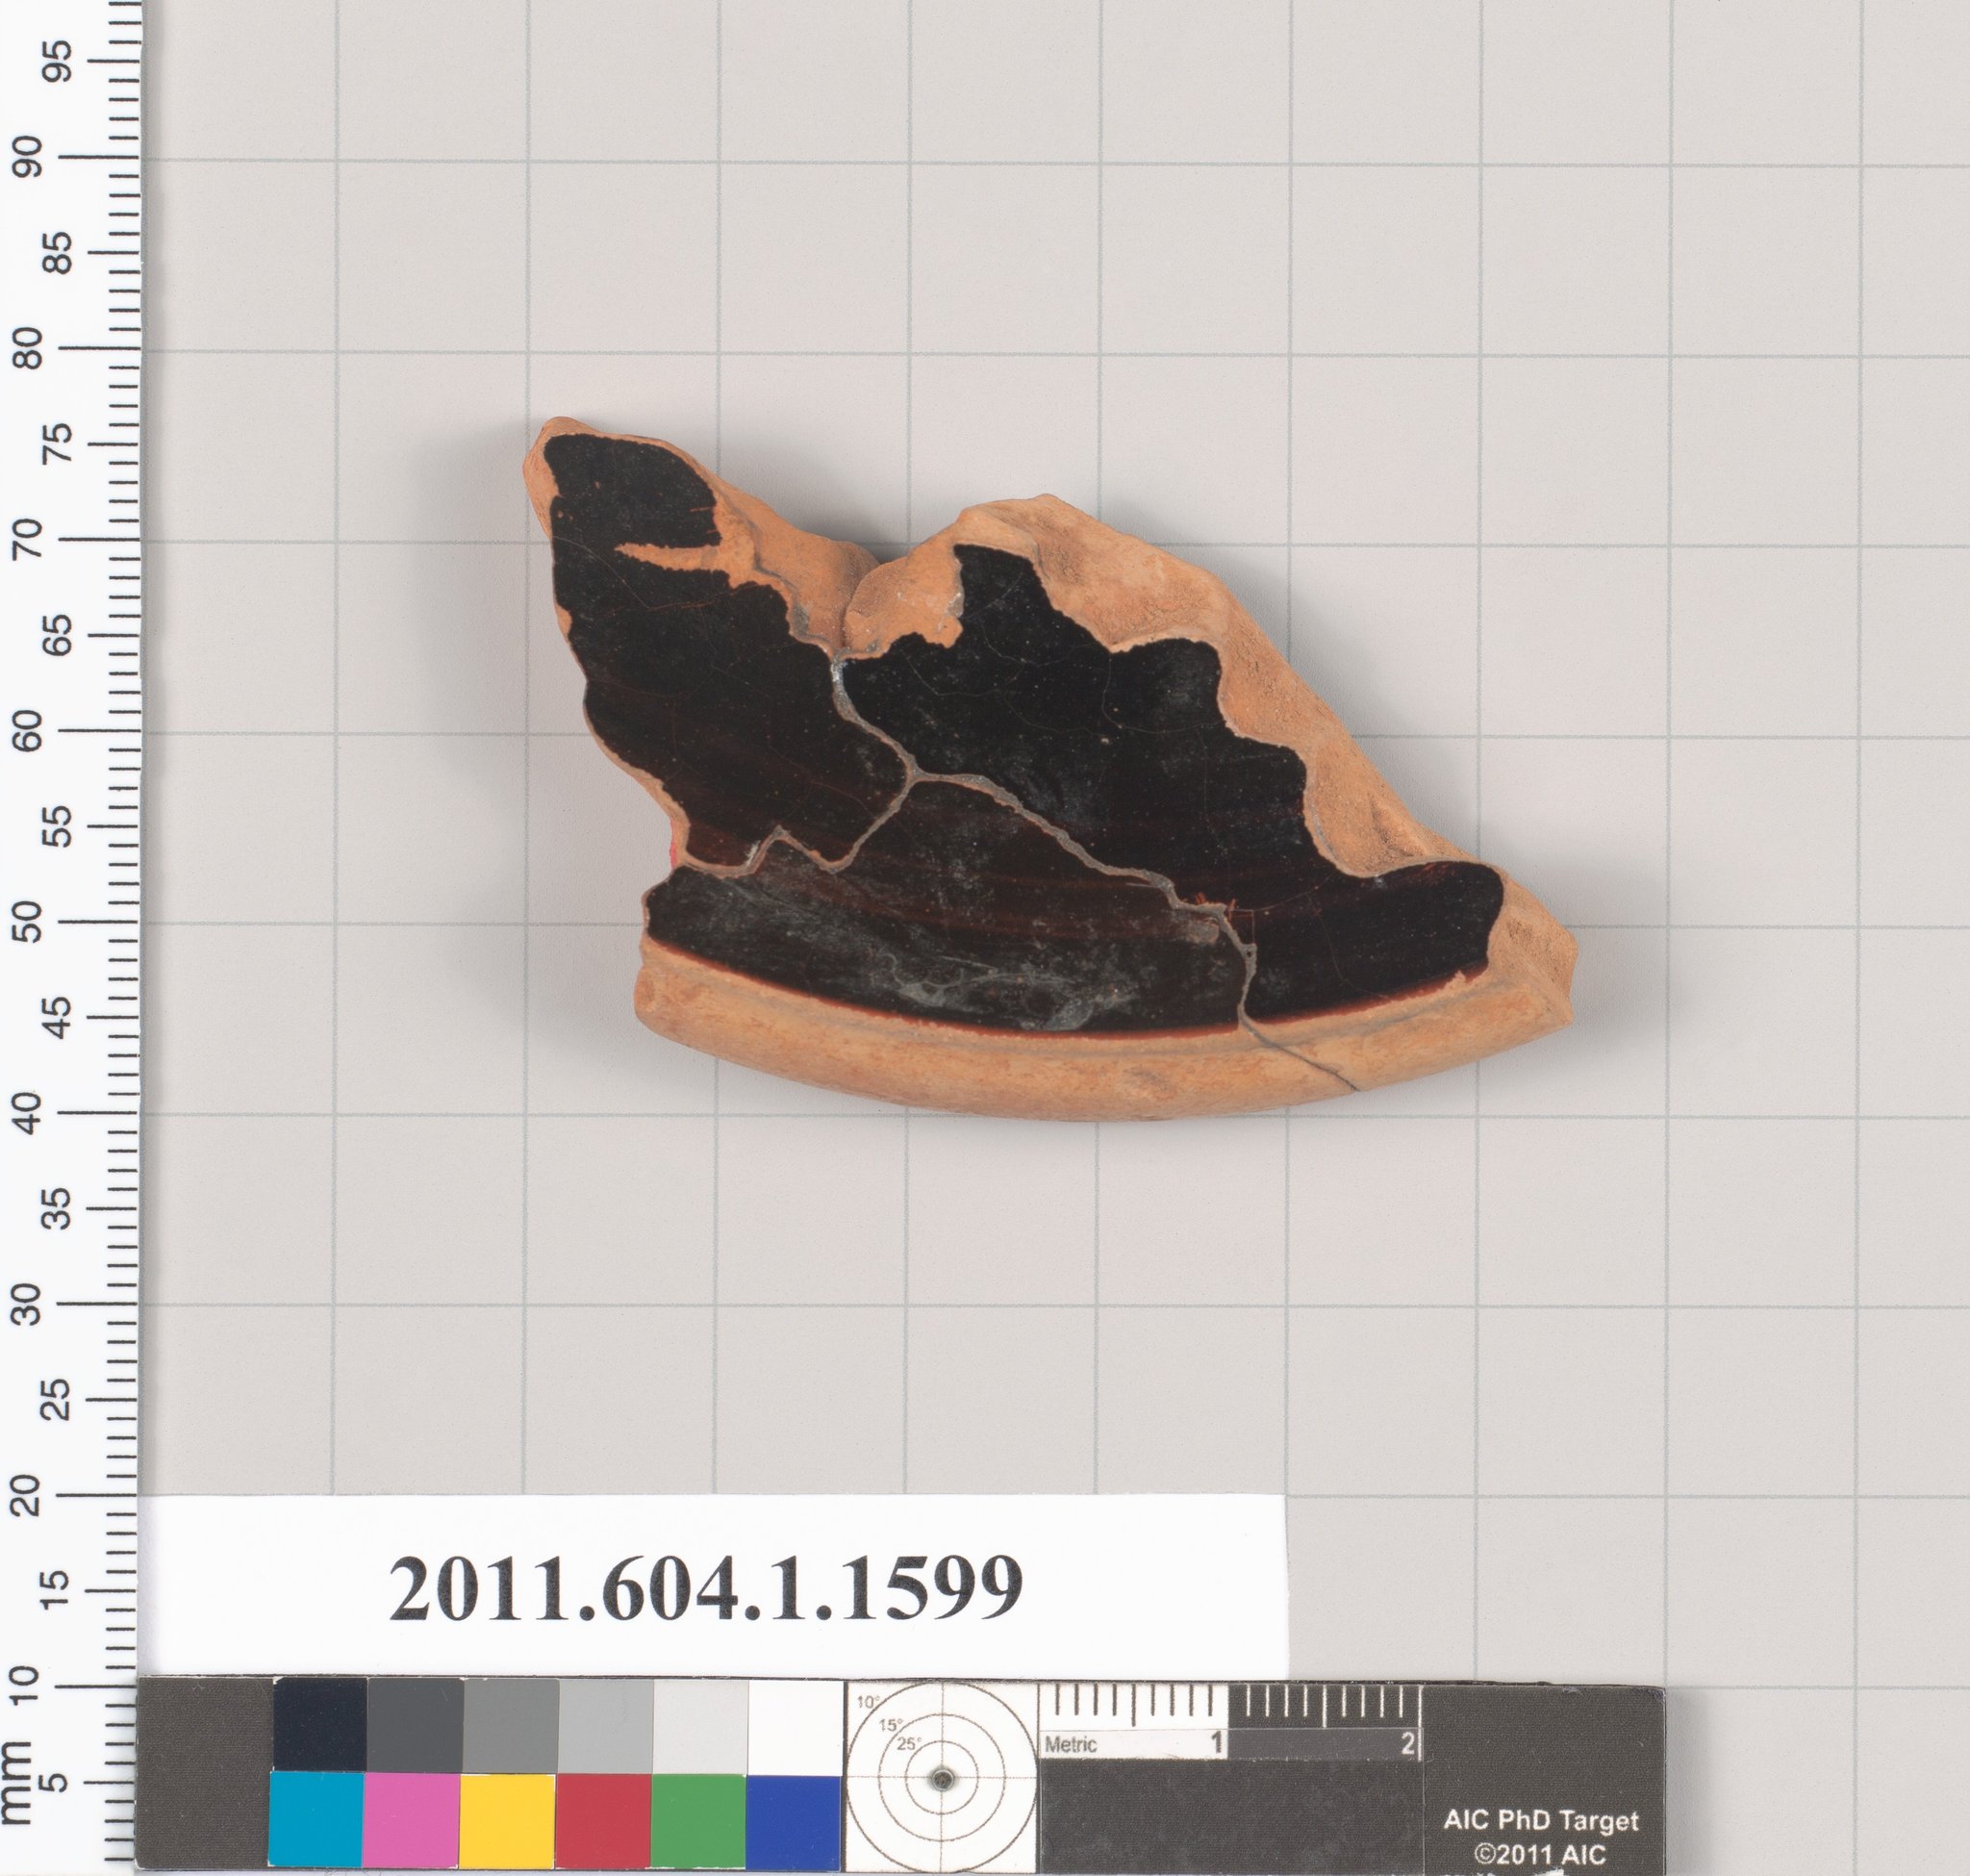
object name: kylix fragment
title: Terracotta fragment of a kylix? (drinking cup)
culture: greek, attic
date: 500-401 BCE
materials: terracotta